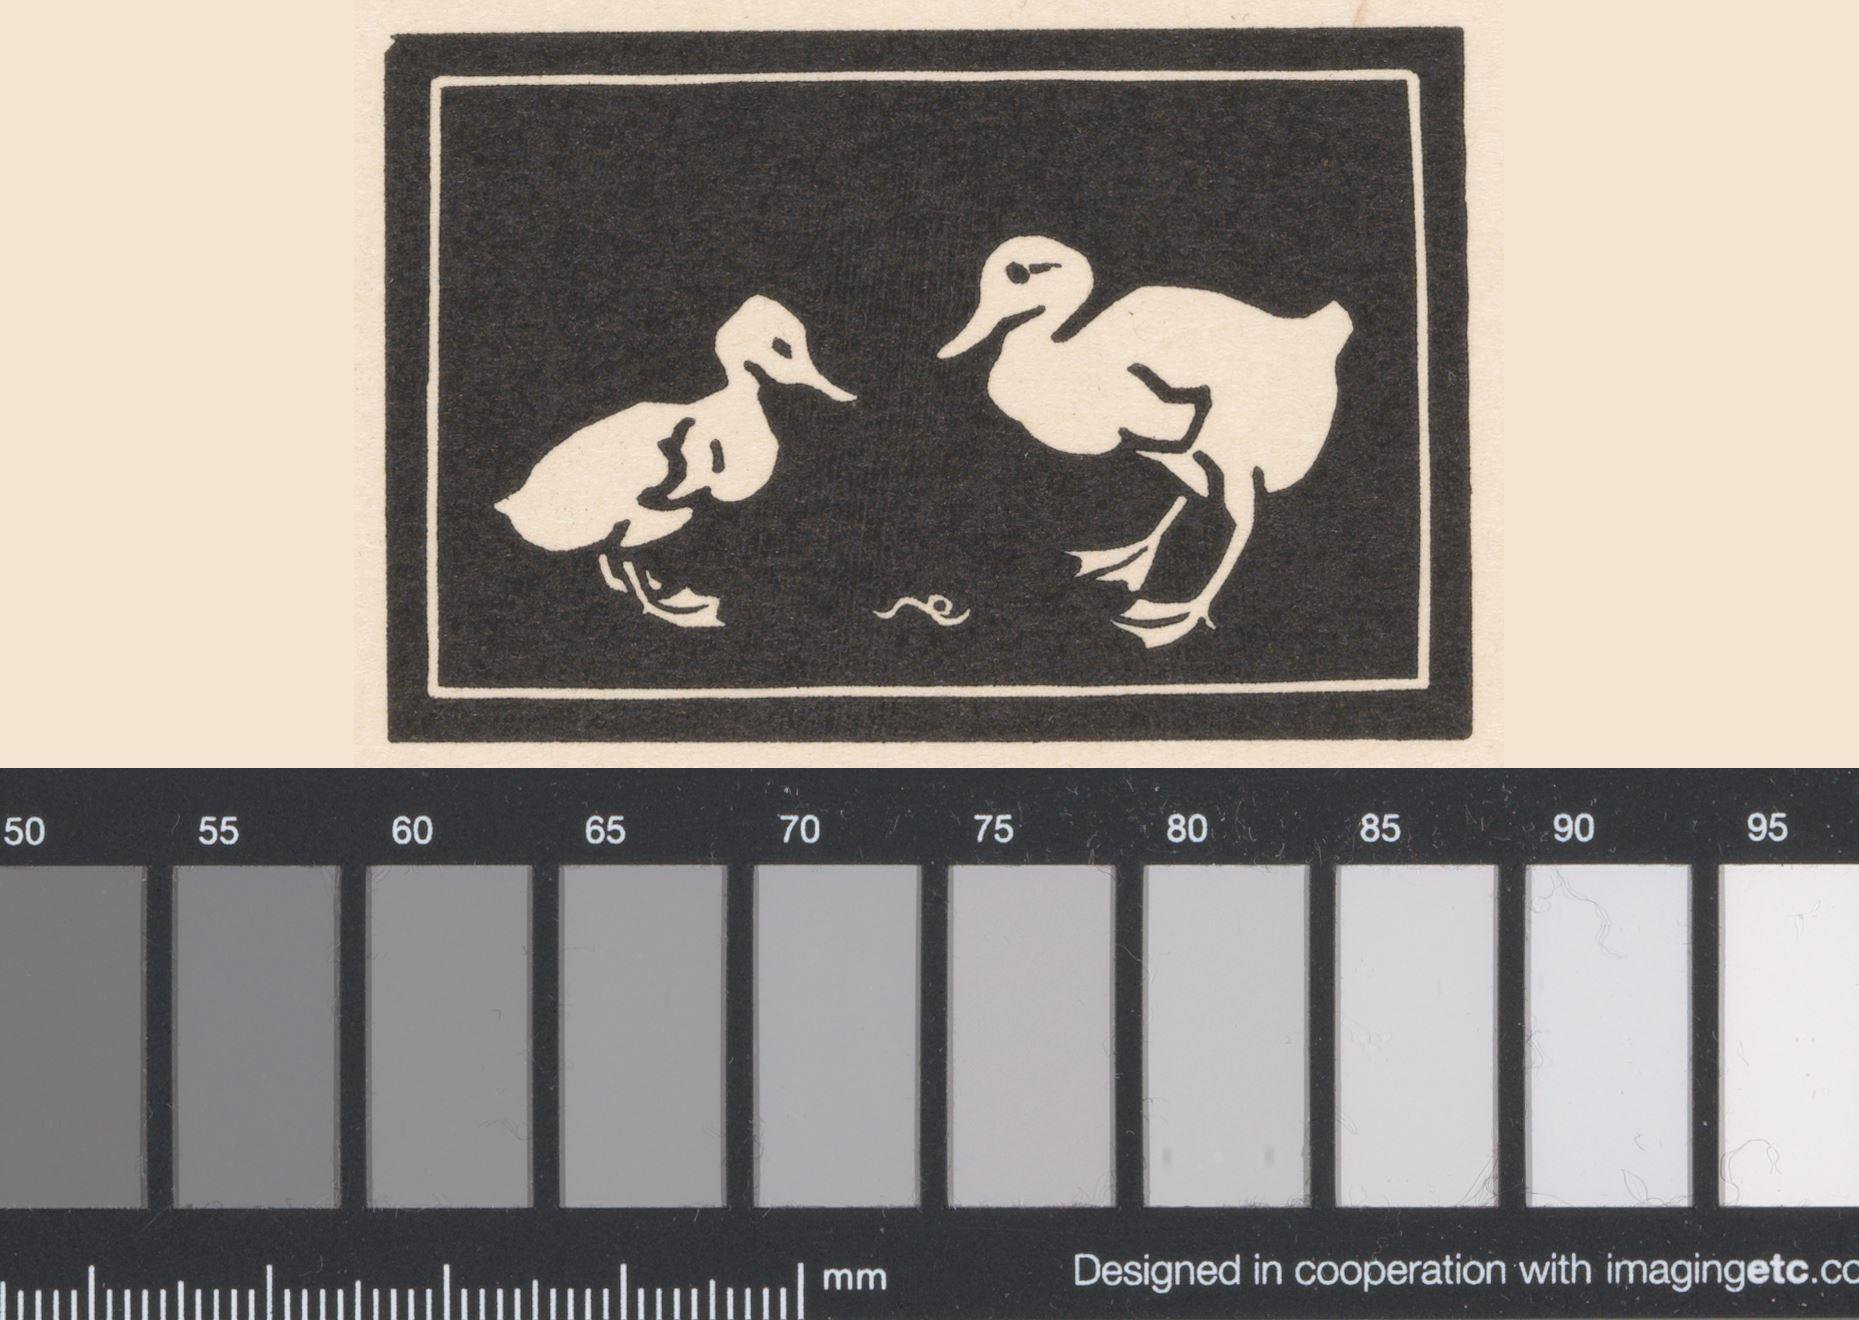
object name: print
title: Twee eendenkuikens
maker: julie de graag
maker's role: draughtsman, print maker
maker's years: 1877-1924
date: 1923-1924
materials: paper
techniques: woodcut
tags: water-birds: duck (+ young animal)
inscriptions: collector's mark: Lugt 2228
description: Prent op een onversneden blad met zes andere prenten van dieren.